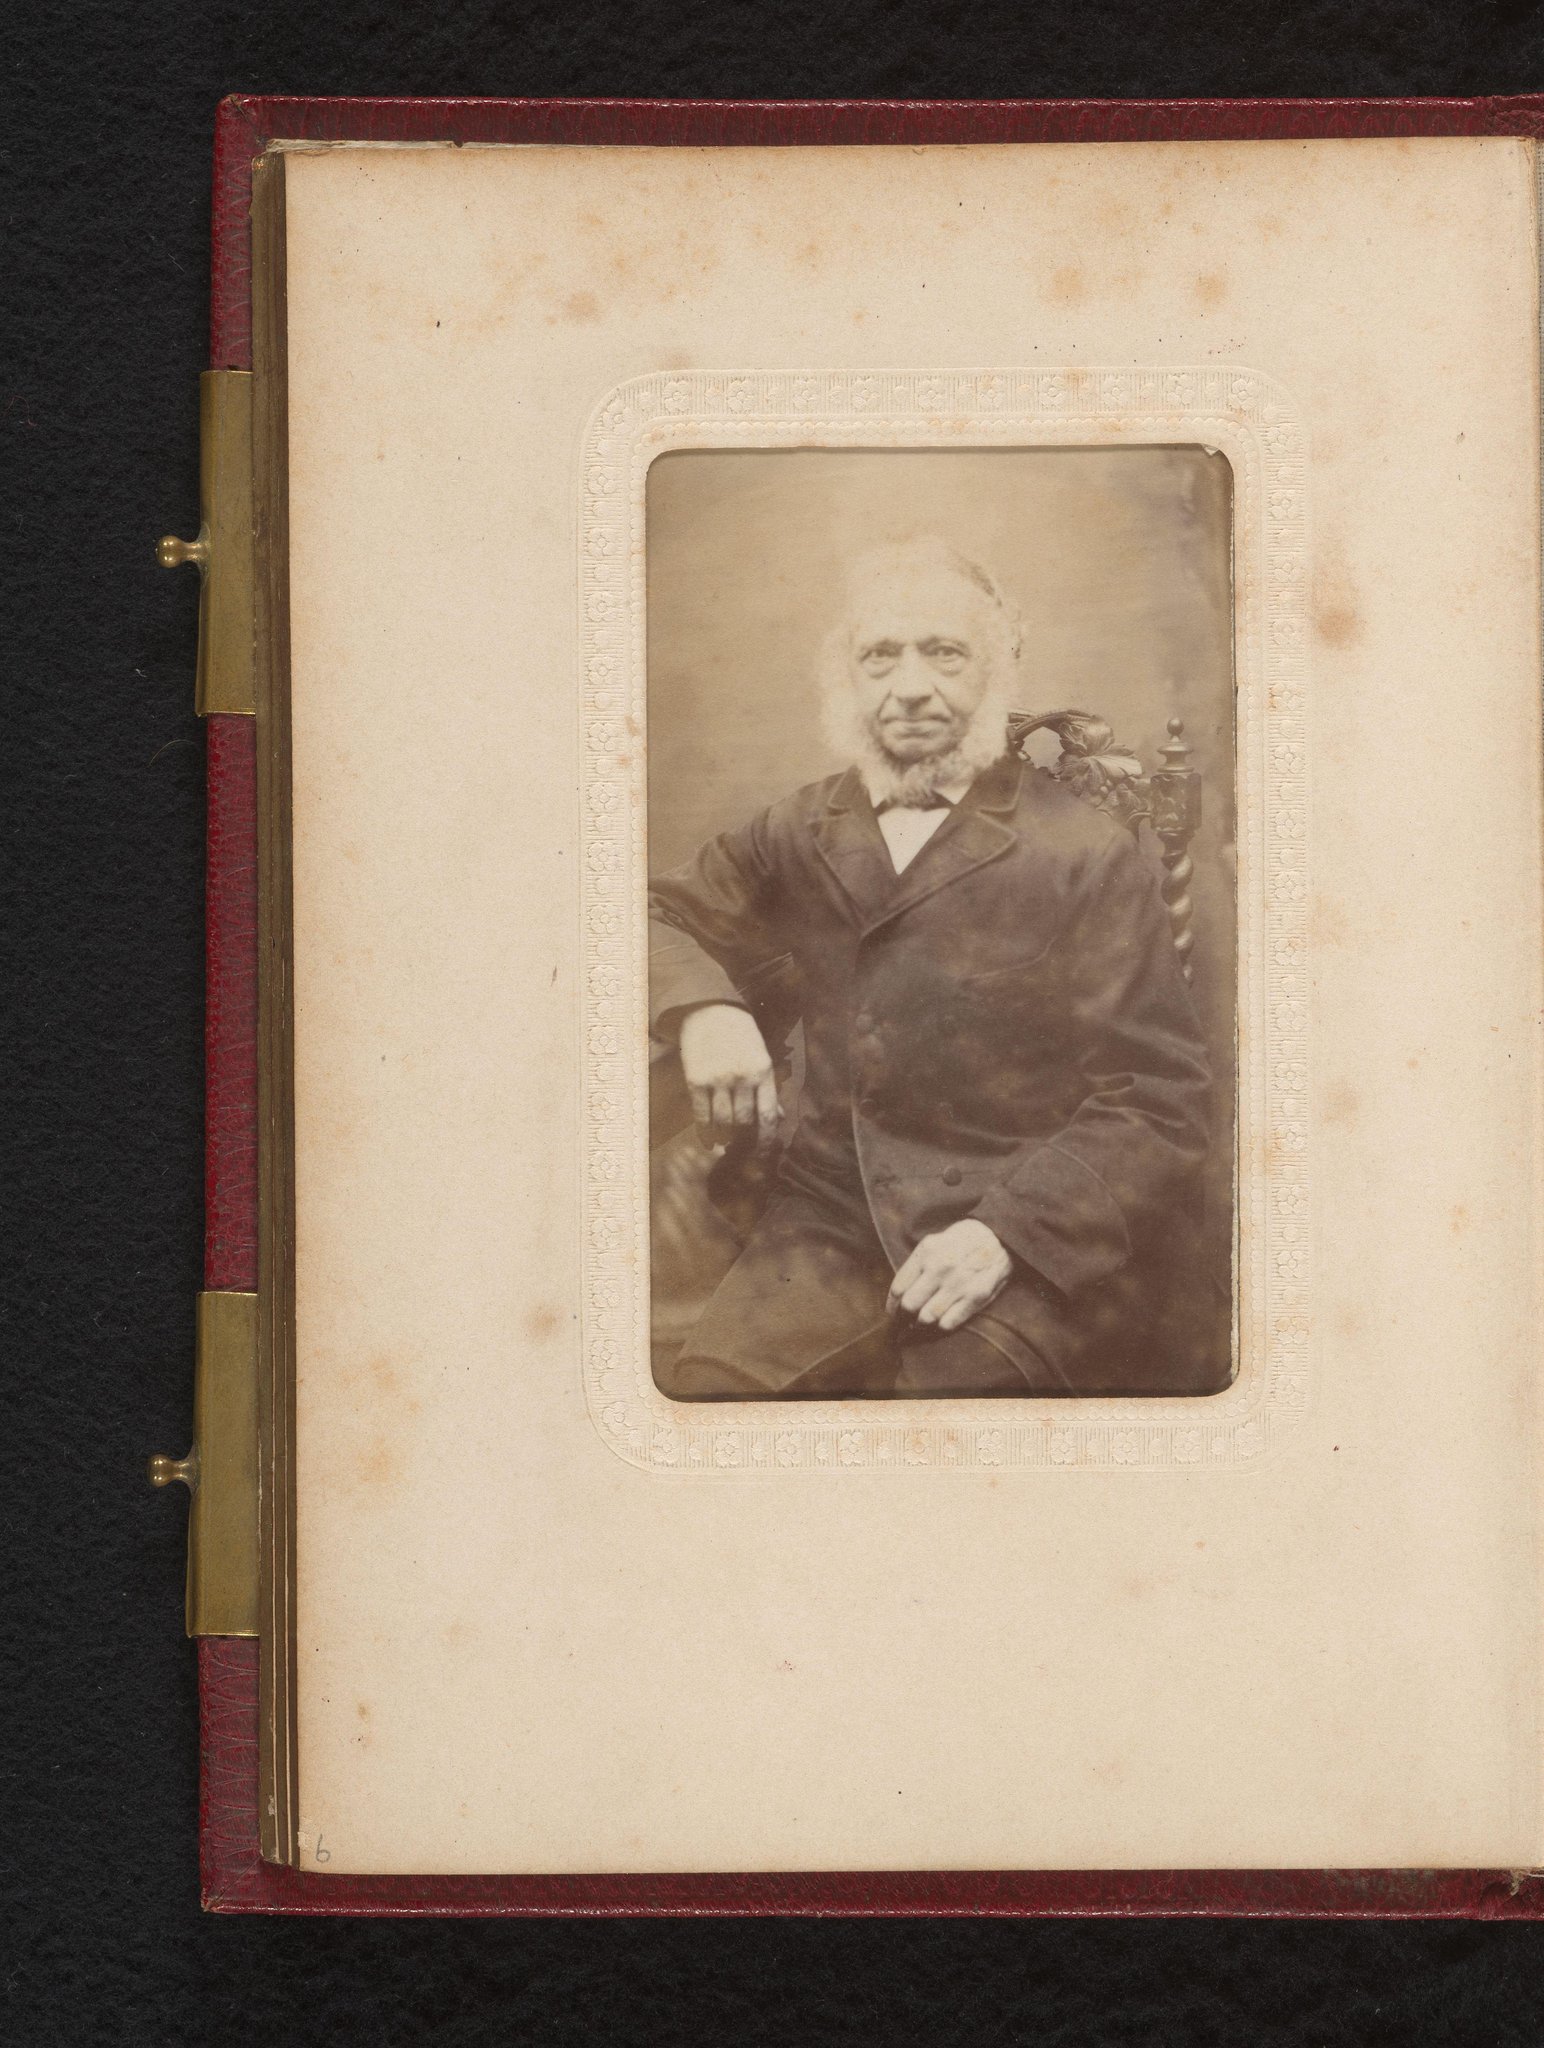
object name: album leaf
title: Portret van een zittende oude man met baard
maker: hermanus jodocus weesing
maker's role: fotograaf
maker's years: 1844-1910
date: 1868-1900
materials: cardboard, celluloid, photographic support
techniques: albumen print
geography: amsterdam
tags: sitting figure, historical persons, old man, beard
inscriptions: inscription: ‘H. J. Weesing,/ PHOTOGRAAF./ Binnen Brouwerstraat 5,/ Amsterdam.’